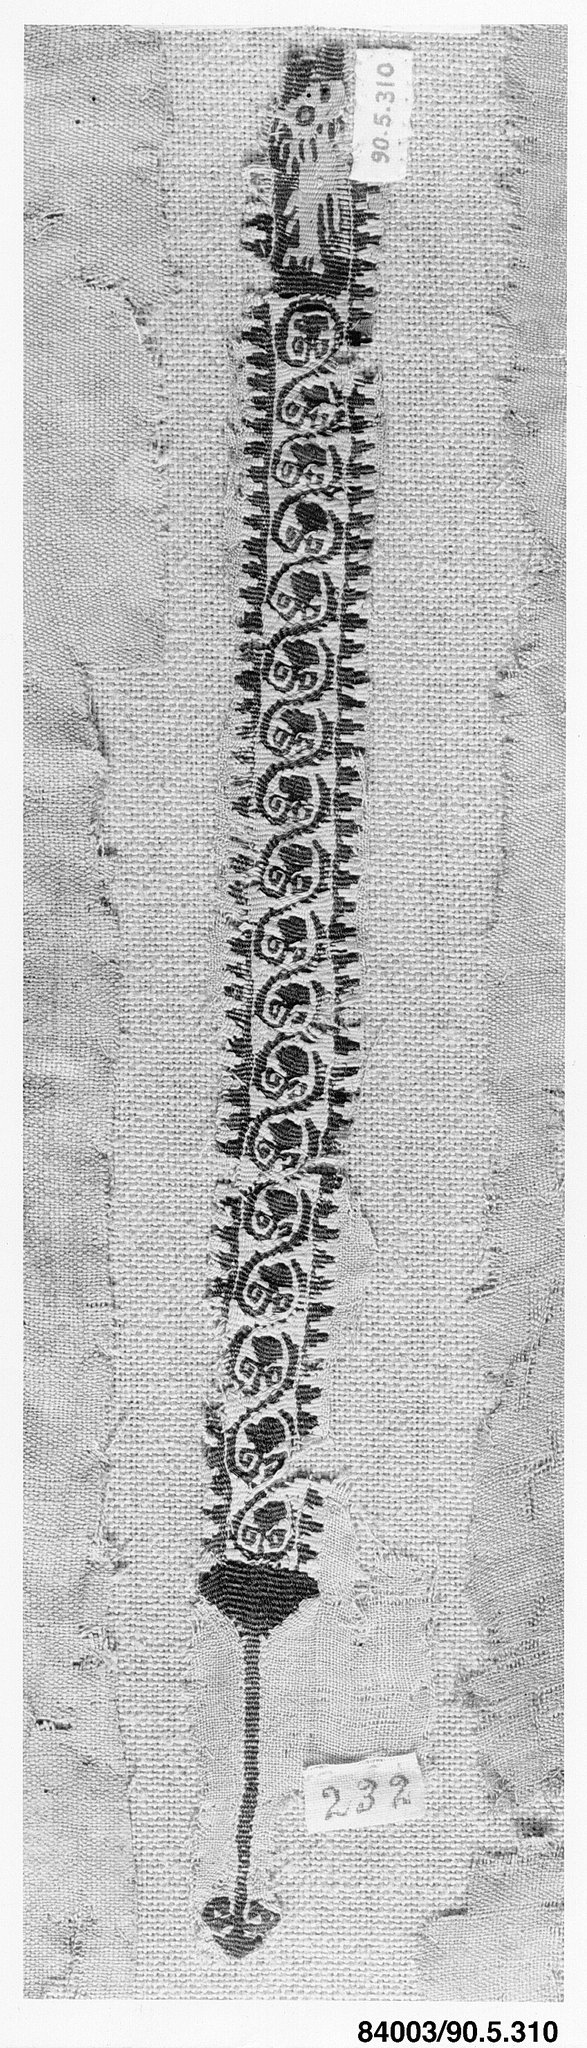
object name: textile fragment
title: Fragment of a Tunic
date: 201-400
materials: linen, wool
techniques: weave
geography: egypt